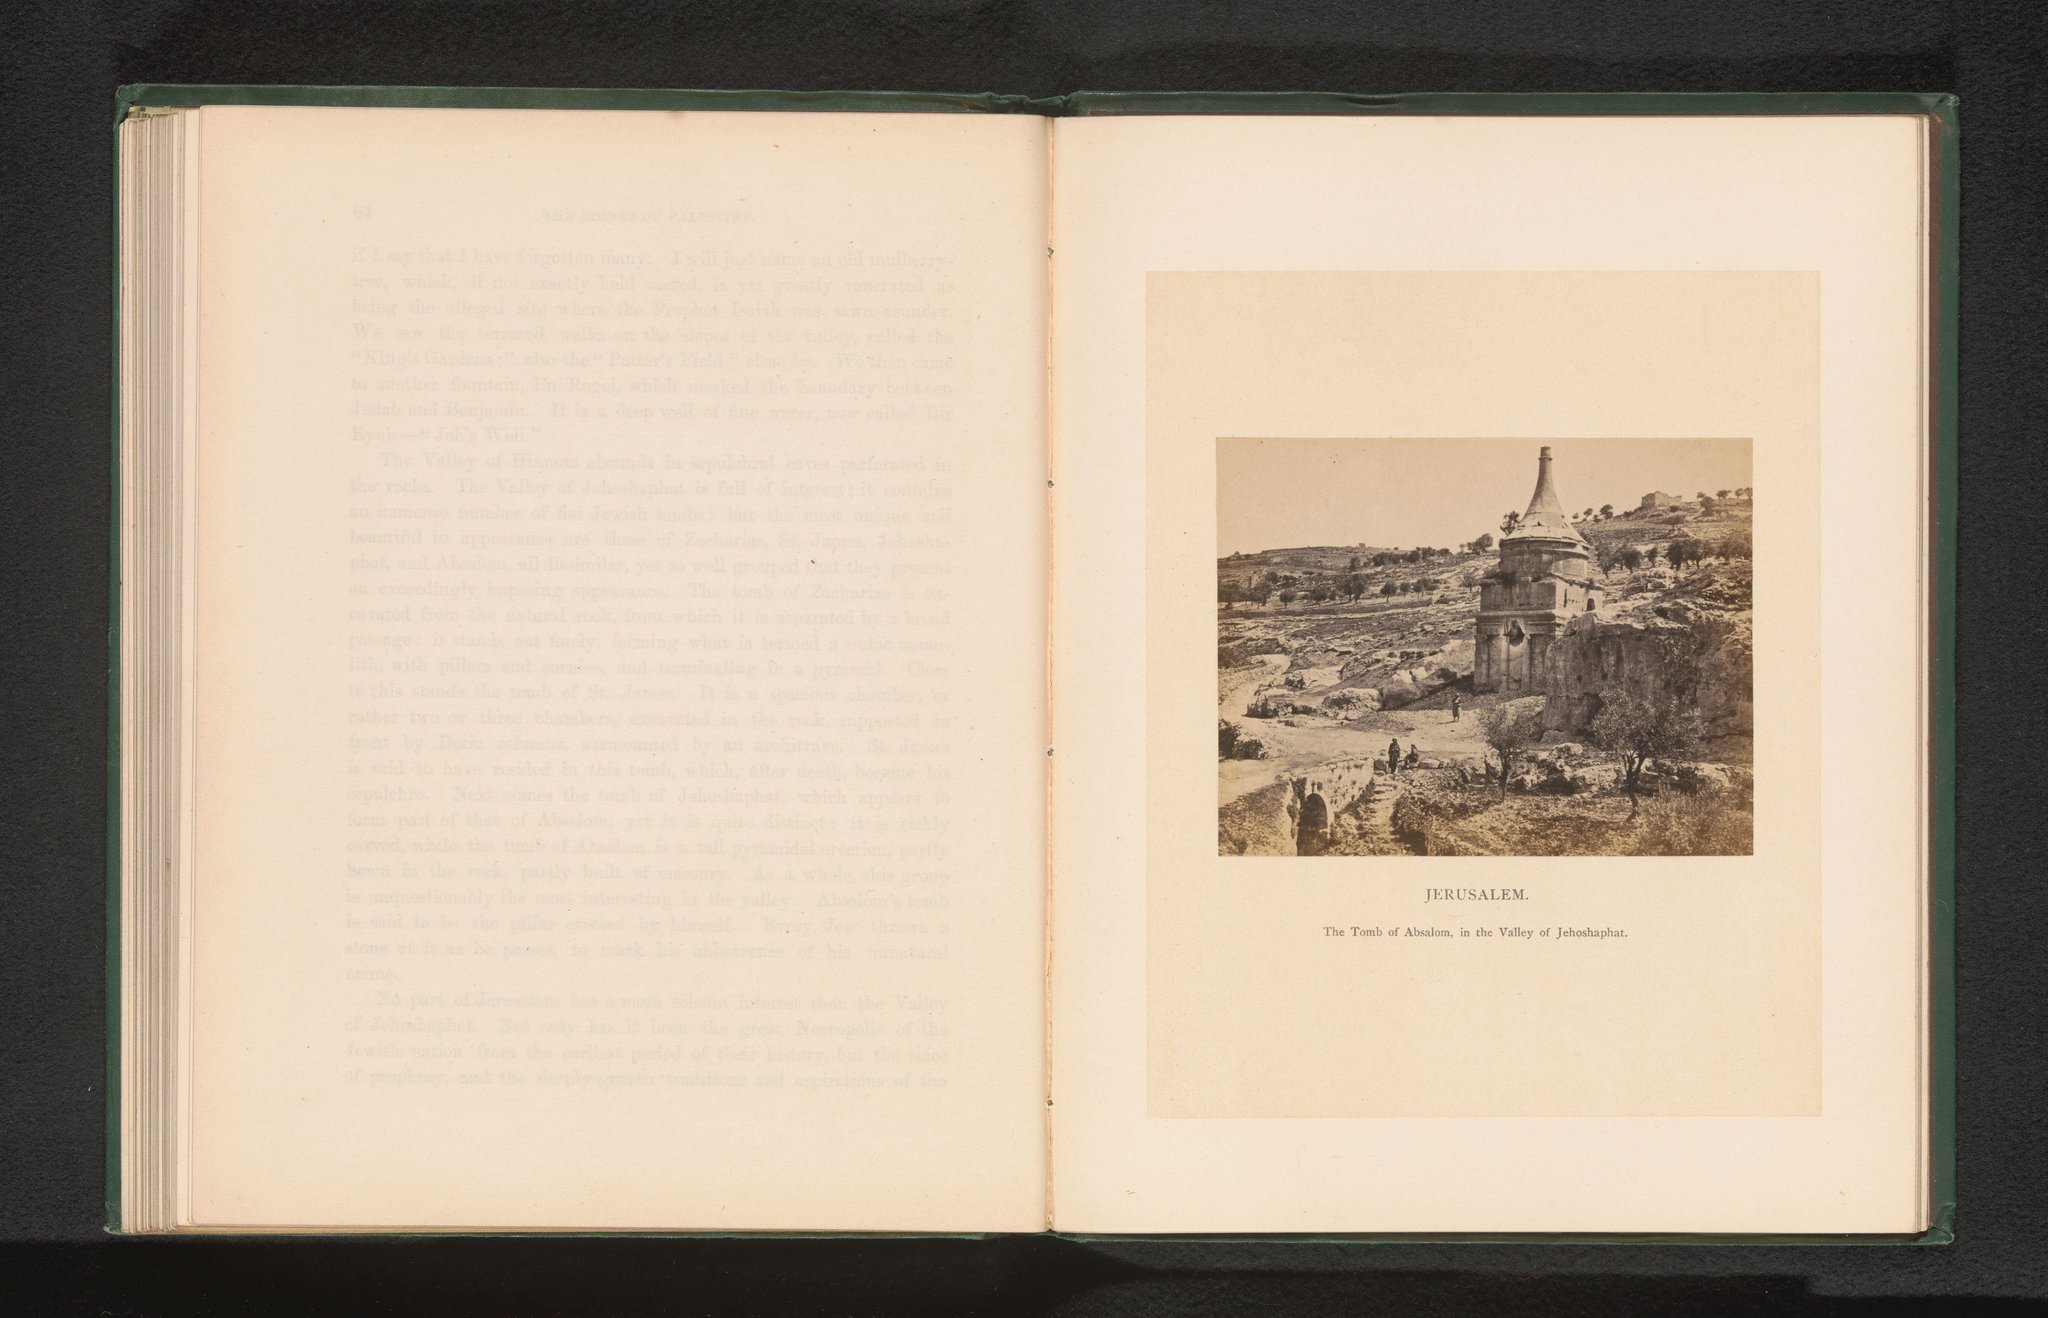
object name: photograph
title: Jerusalem. The Tomb of Absalom, in the Valley of Jehoshaphat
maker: francis bedford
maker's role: print maker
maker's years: 1815-1894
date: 1860-1865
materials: photographic support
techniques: albumen print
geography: kidron valley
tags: grave, tomb